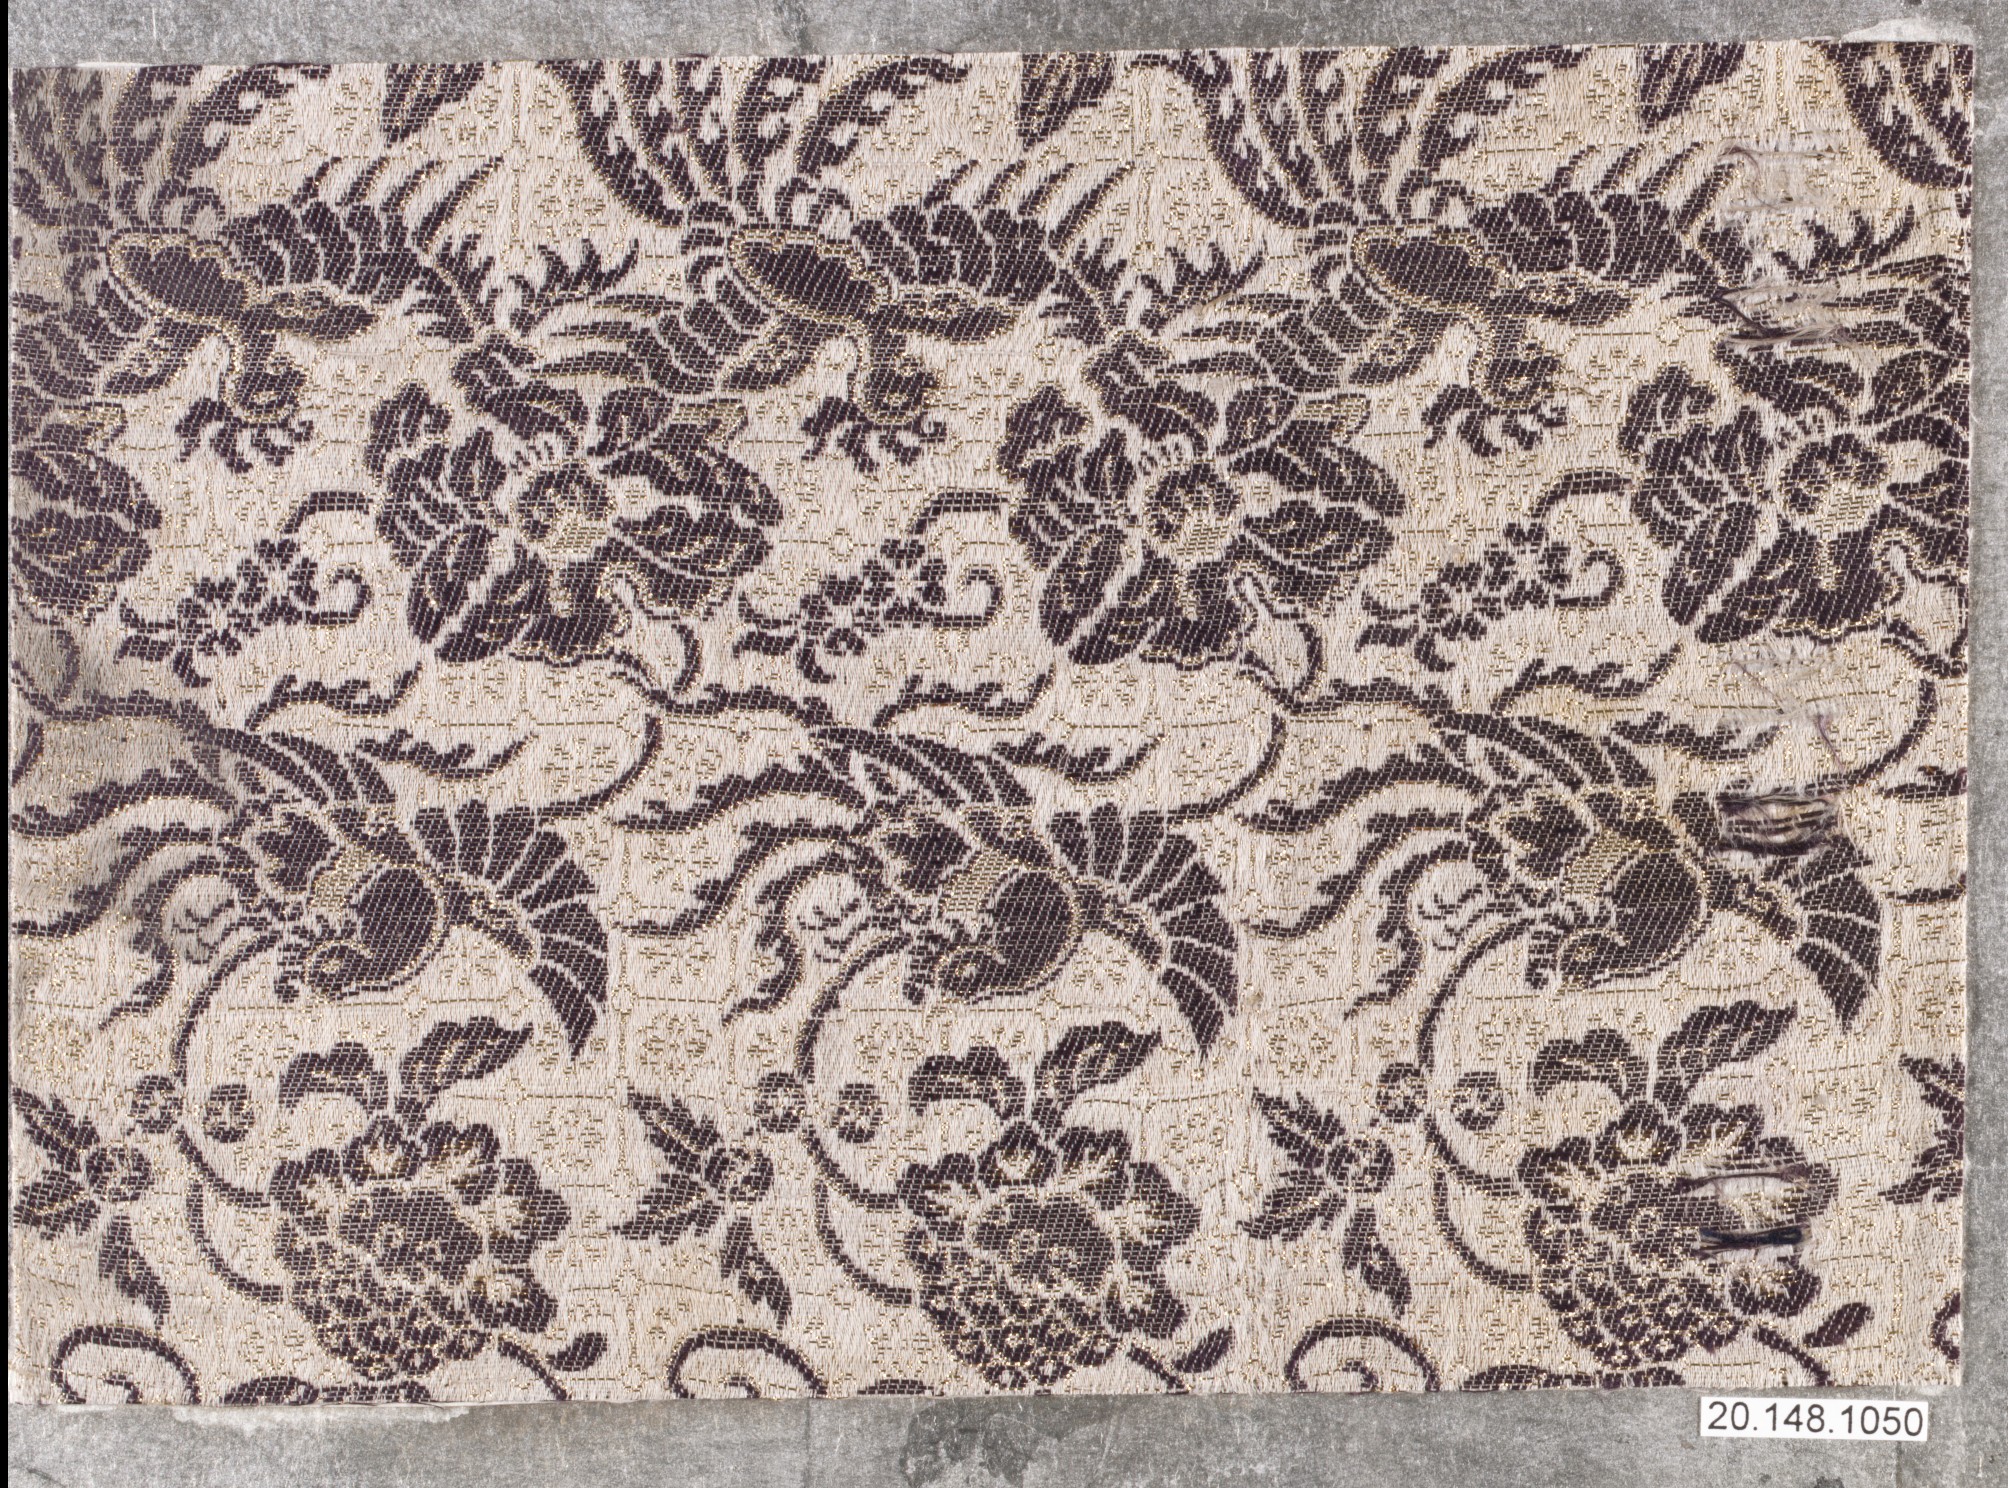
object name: piece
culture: japanese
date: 1801-1900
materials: silk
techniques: compound weave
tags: birds,flowers